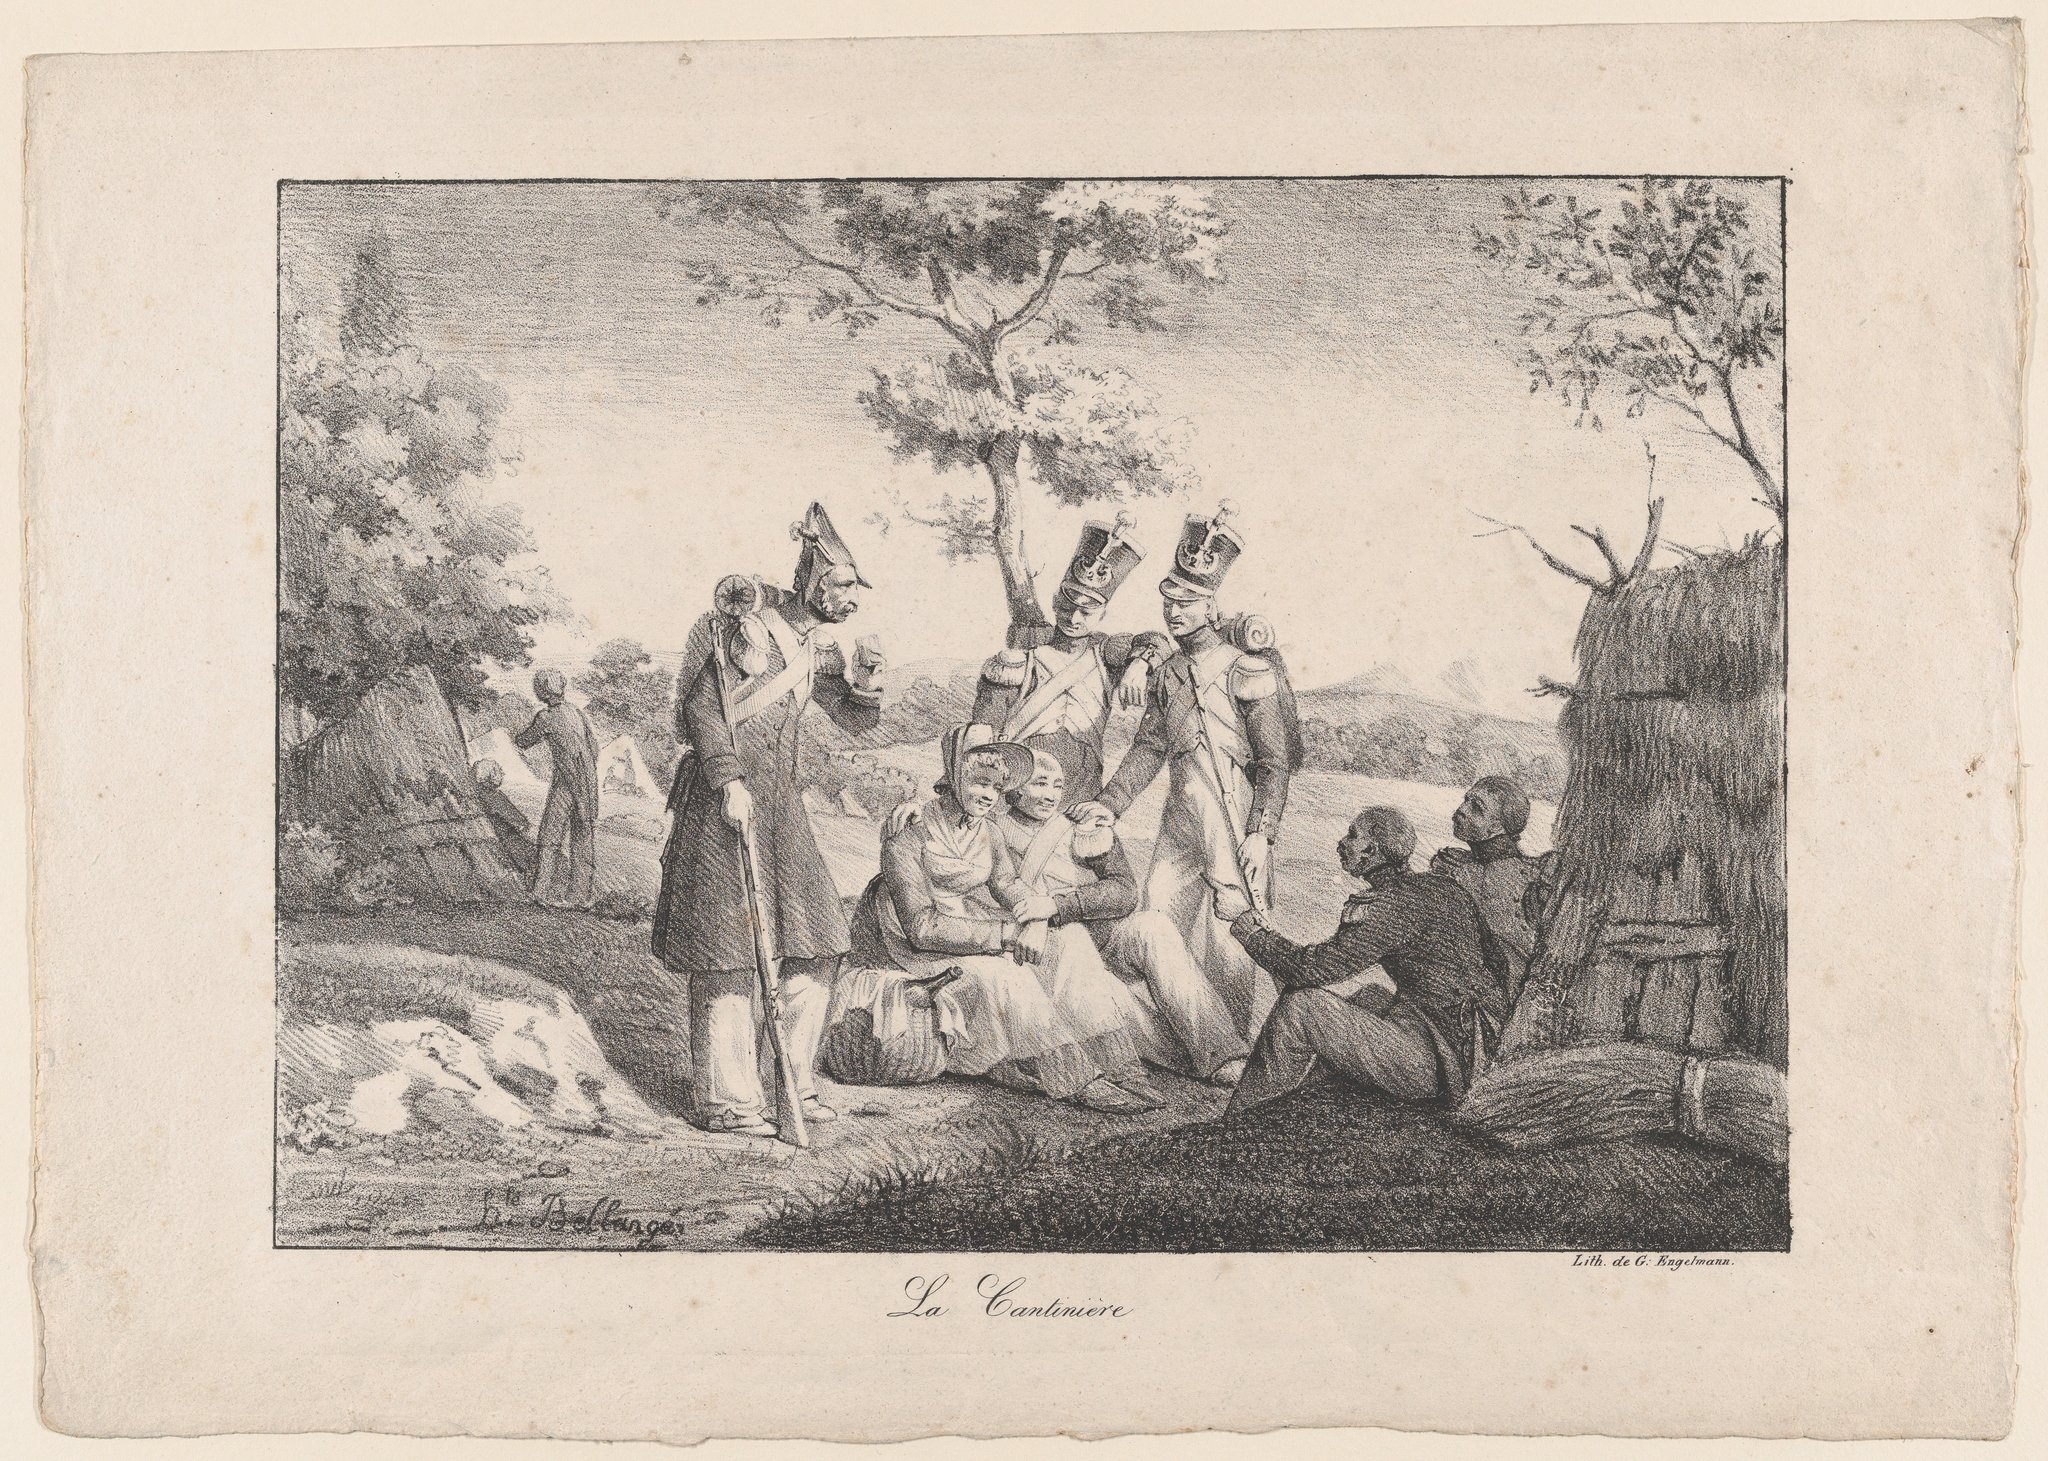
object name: print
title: The Lunch Lady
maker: hippolyte bellangé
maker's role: artist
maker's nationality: french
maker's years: 1800-1866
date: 1840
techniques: lithograph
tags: men,women,trees